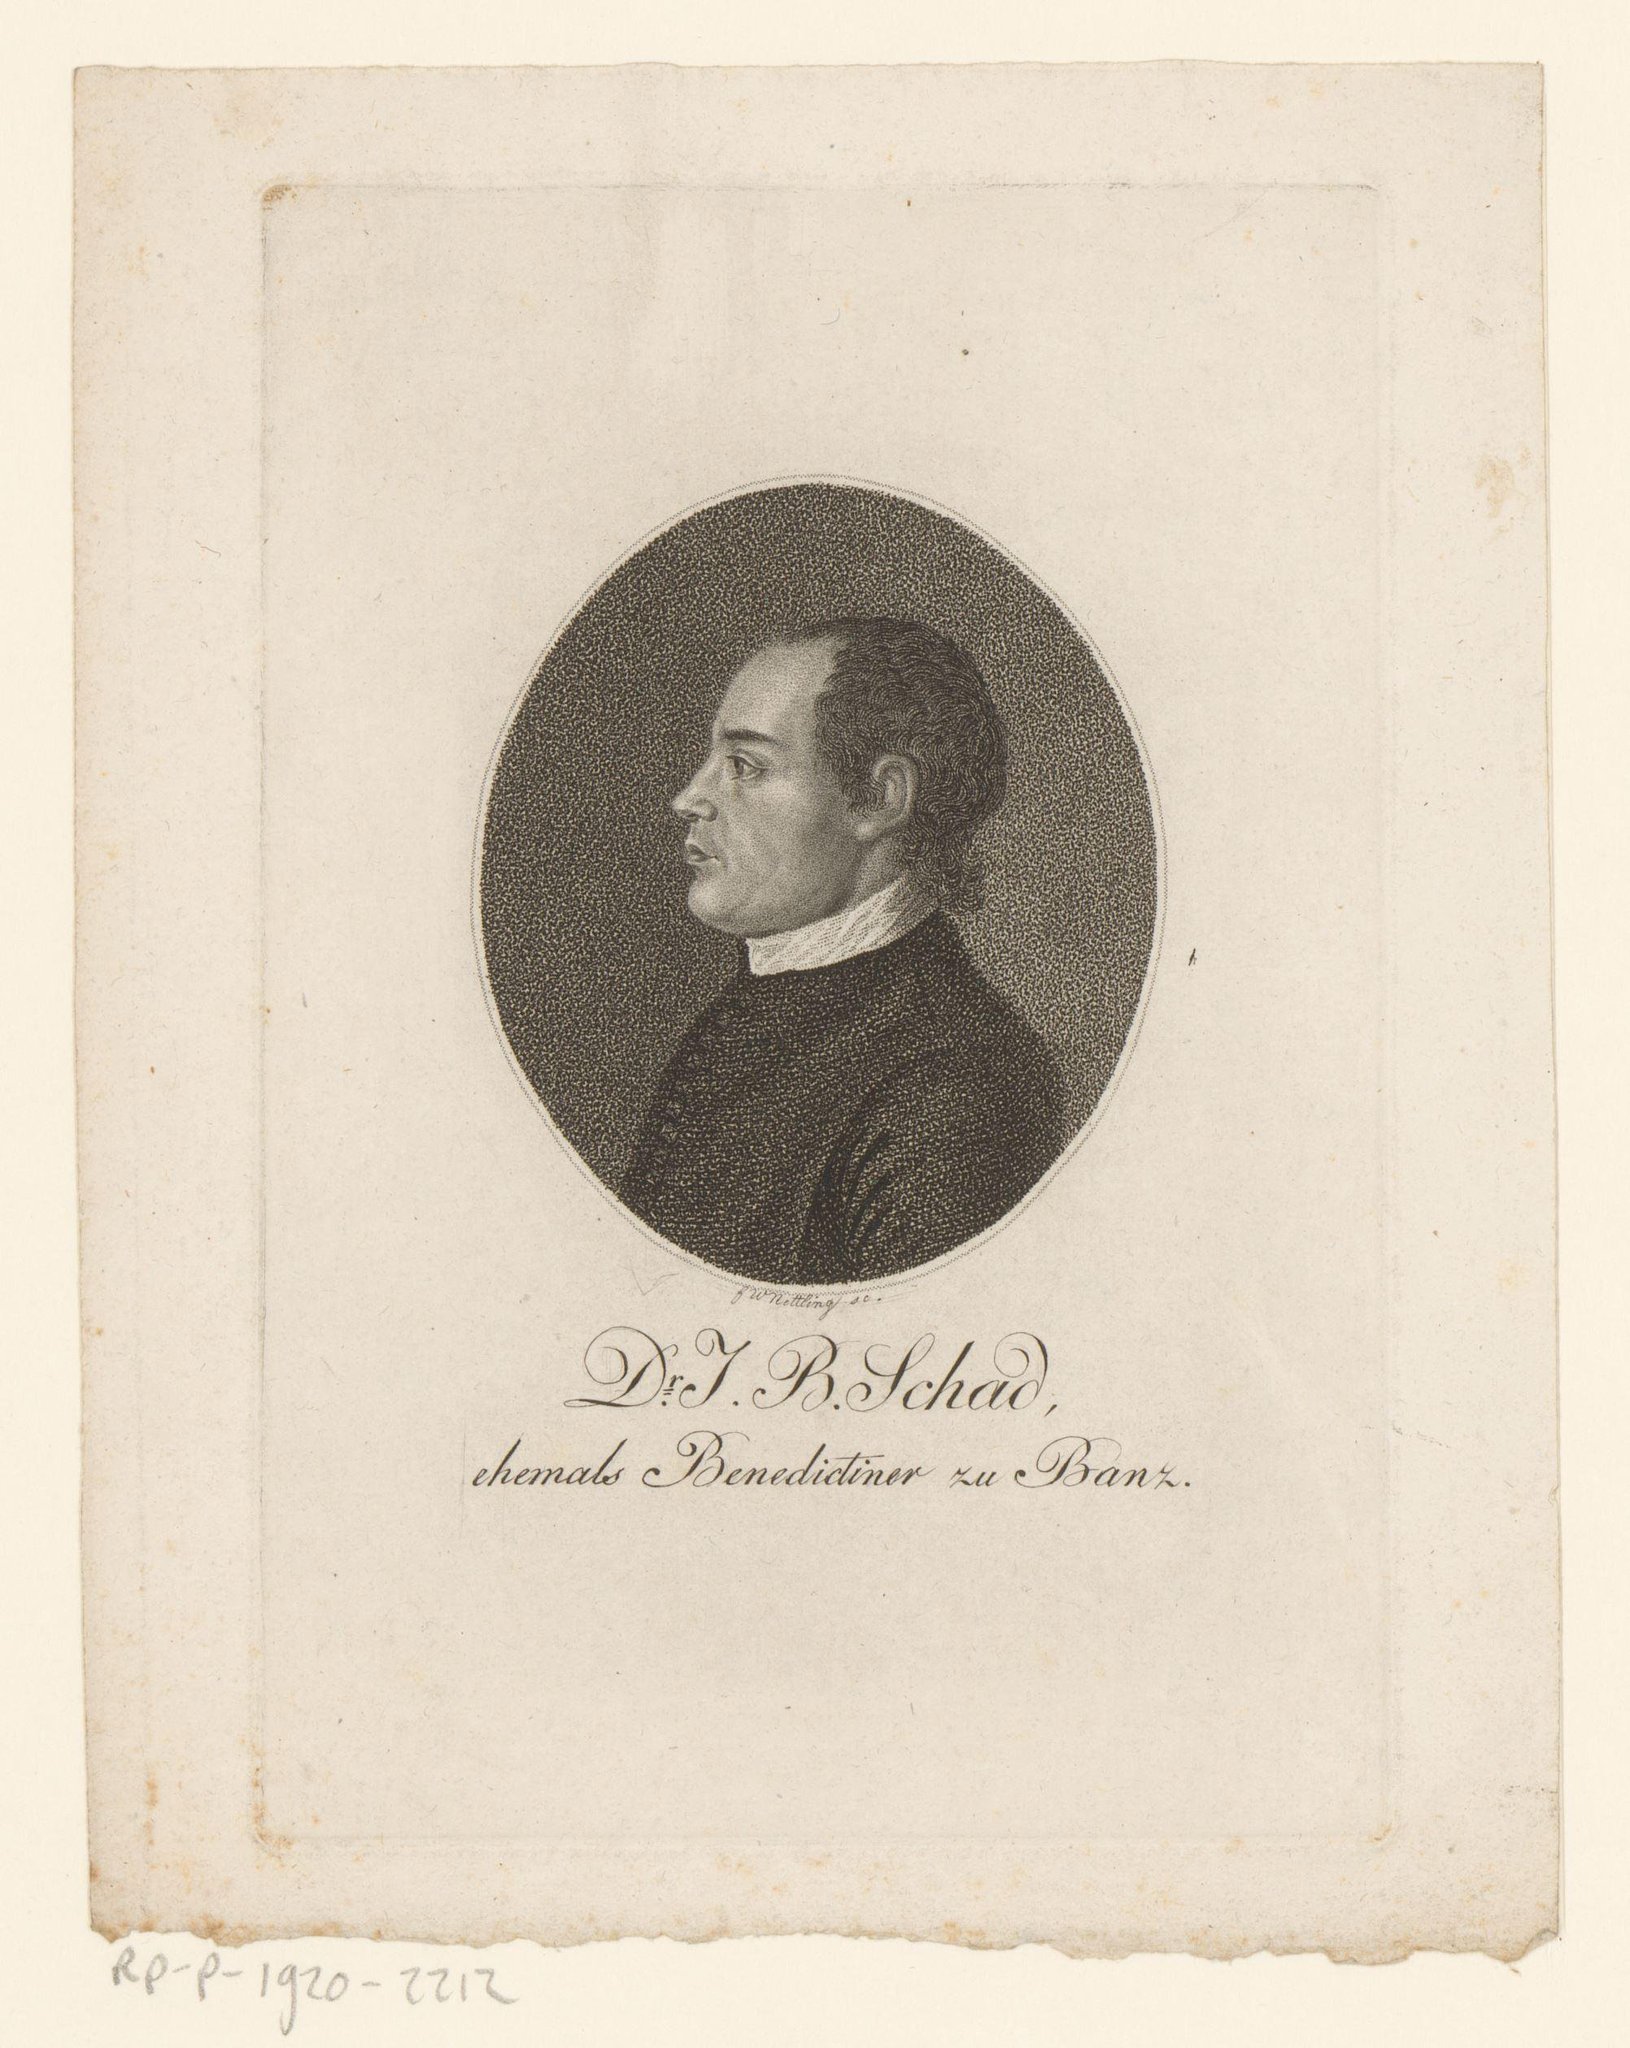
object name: print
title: Portret van Johann Baptist Schad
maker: friedrich wilhelm nettling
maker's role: print maker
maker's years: 1793-1824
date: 1793-1824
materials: paper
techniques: engraving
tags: historical persons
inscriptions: collector's mark: Lugt 2228